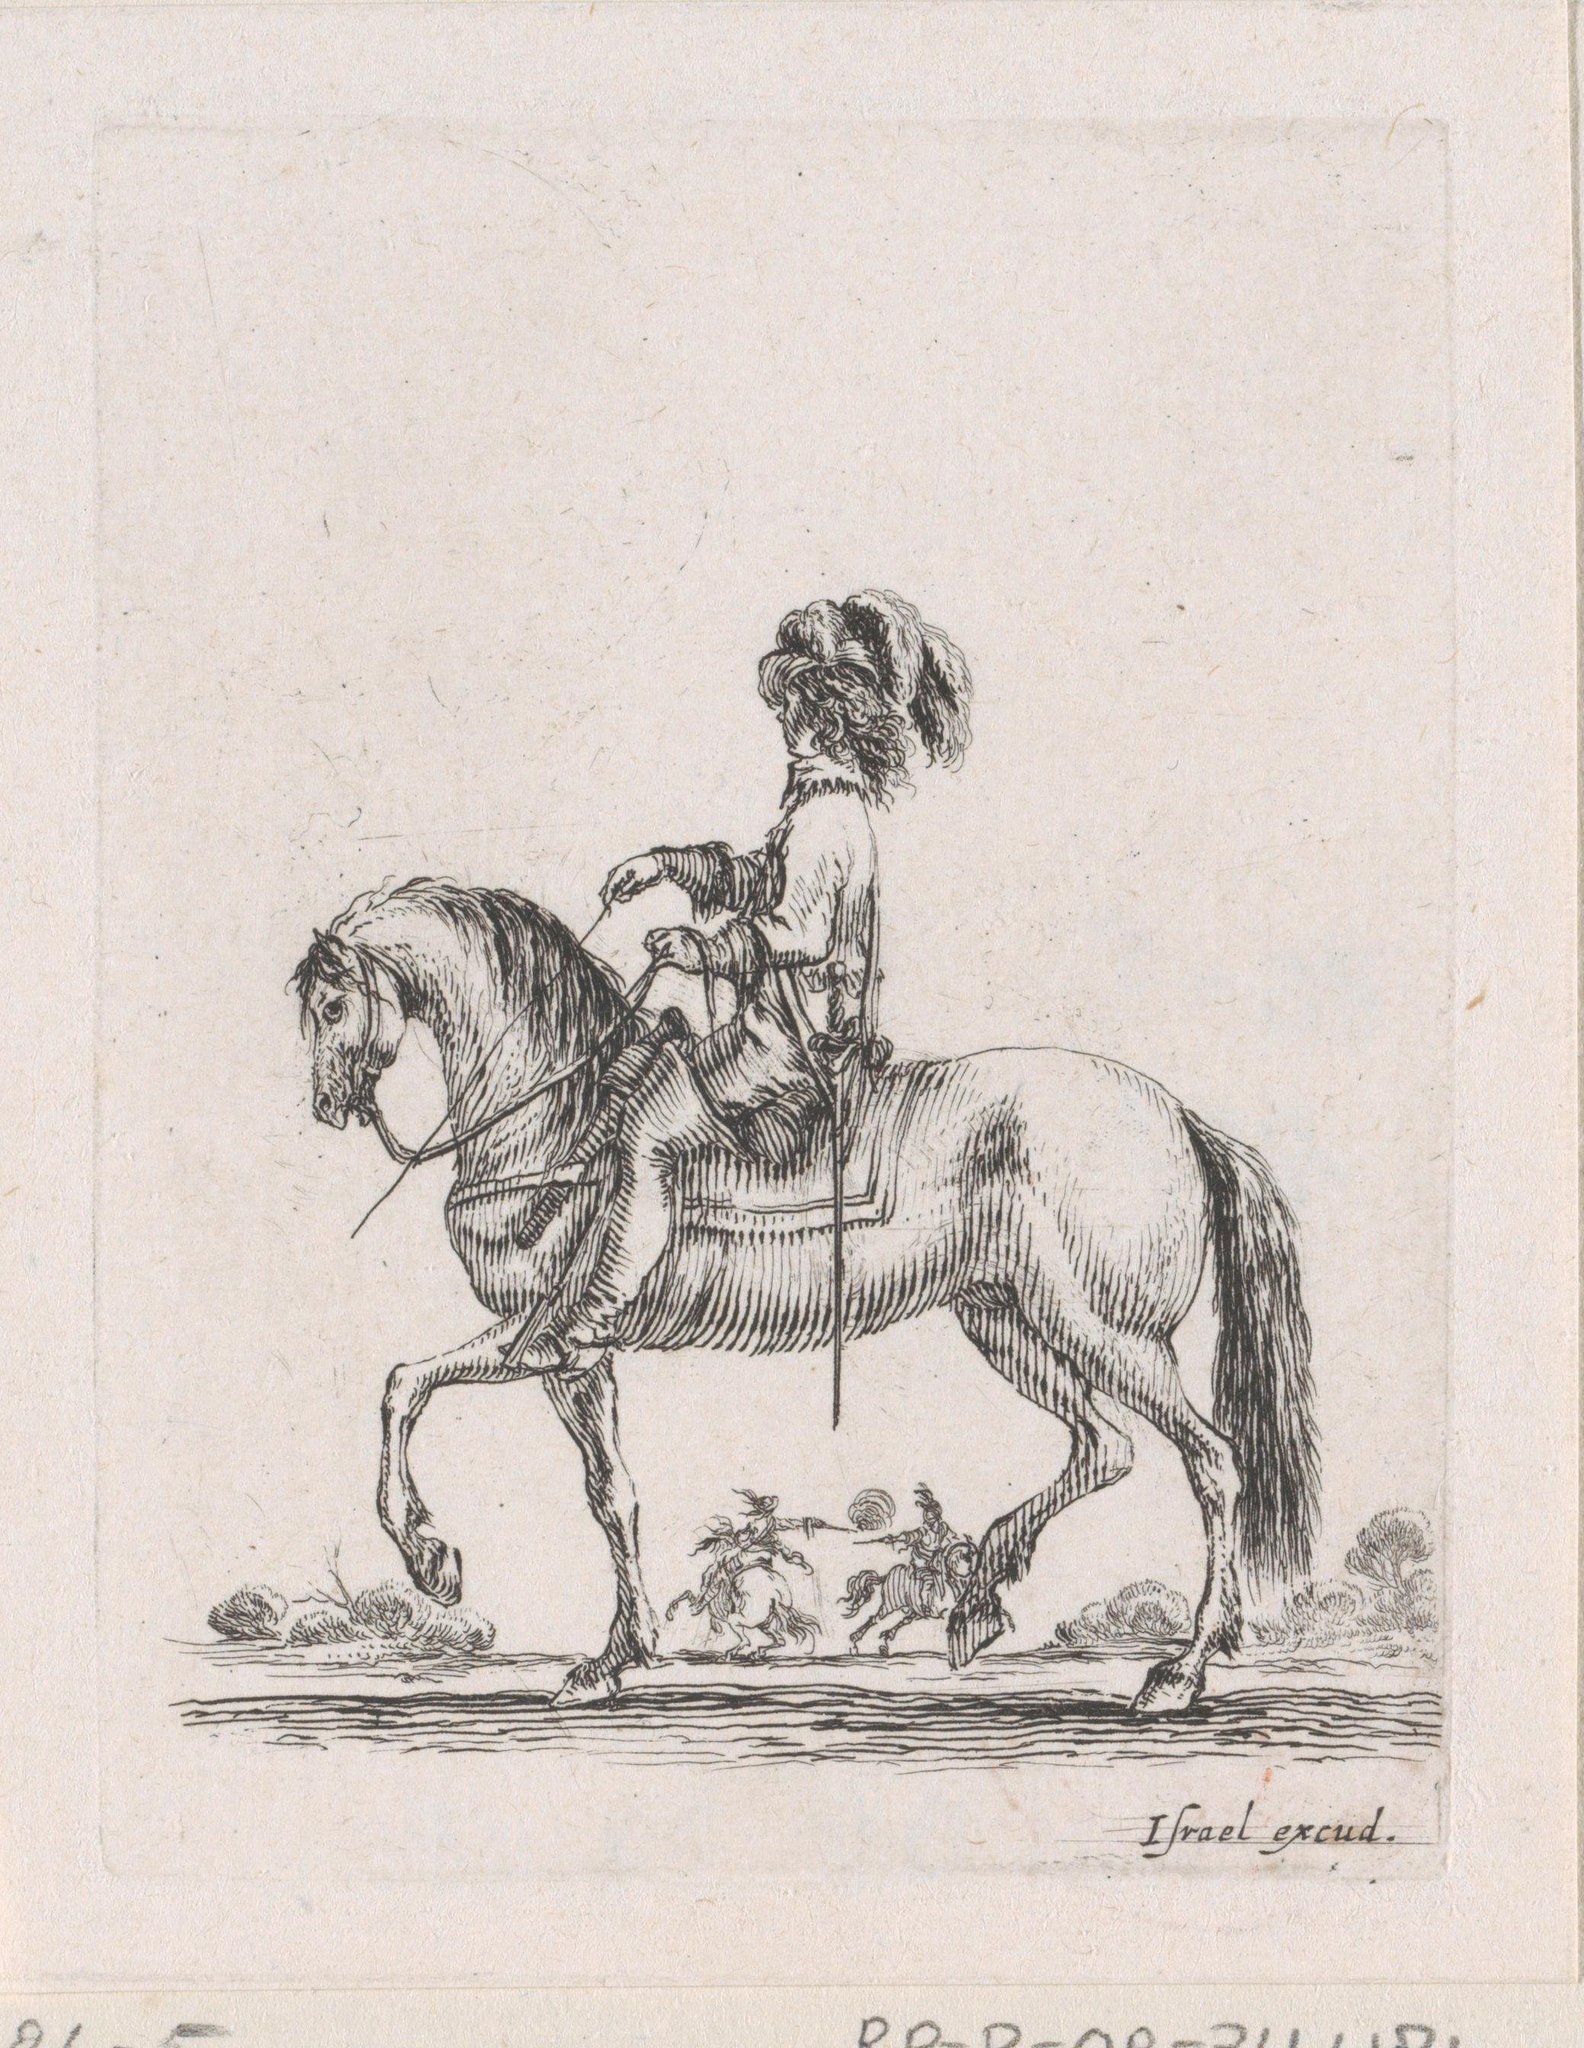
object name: print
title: Diverses exercices de cavalerie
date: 1620-1664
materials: paper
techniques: etching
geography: paris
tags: riding a horse, ass, or mule; rider, horseman, horse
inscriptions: collector's mark: Lugt 240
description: Prent uit een reeks van 19 prenten. Getekende voorstudie wordt bewaard in het British Museum te Londen (inv. nr. 1895-6-17-394).